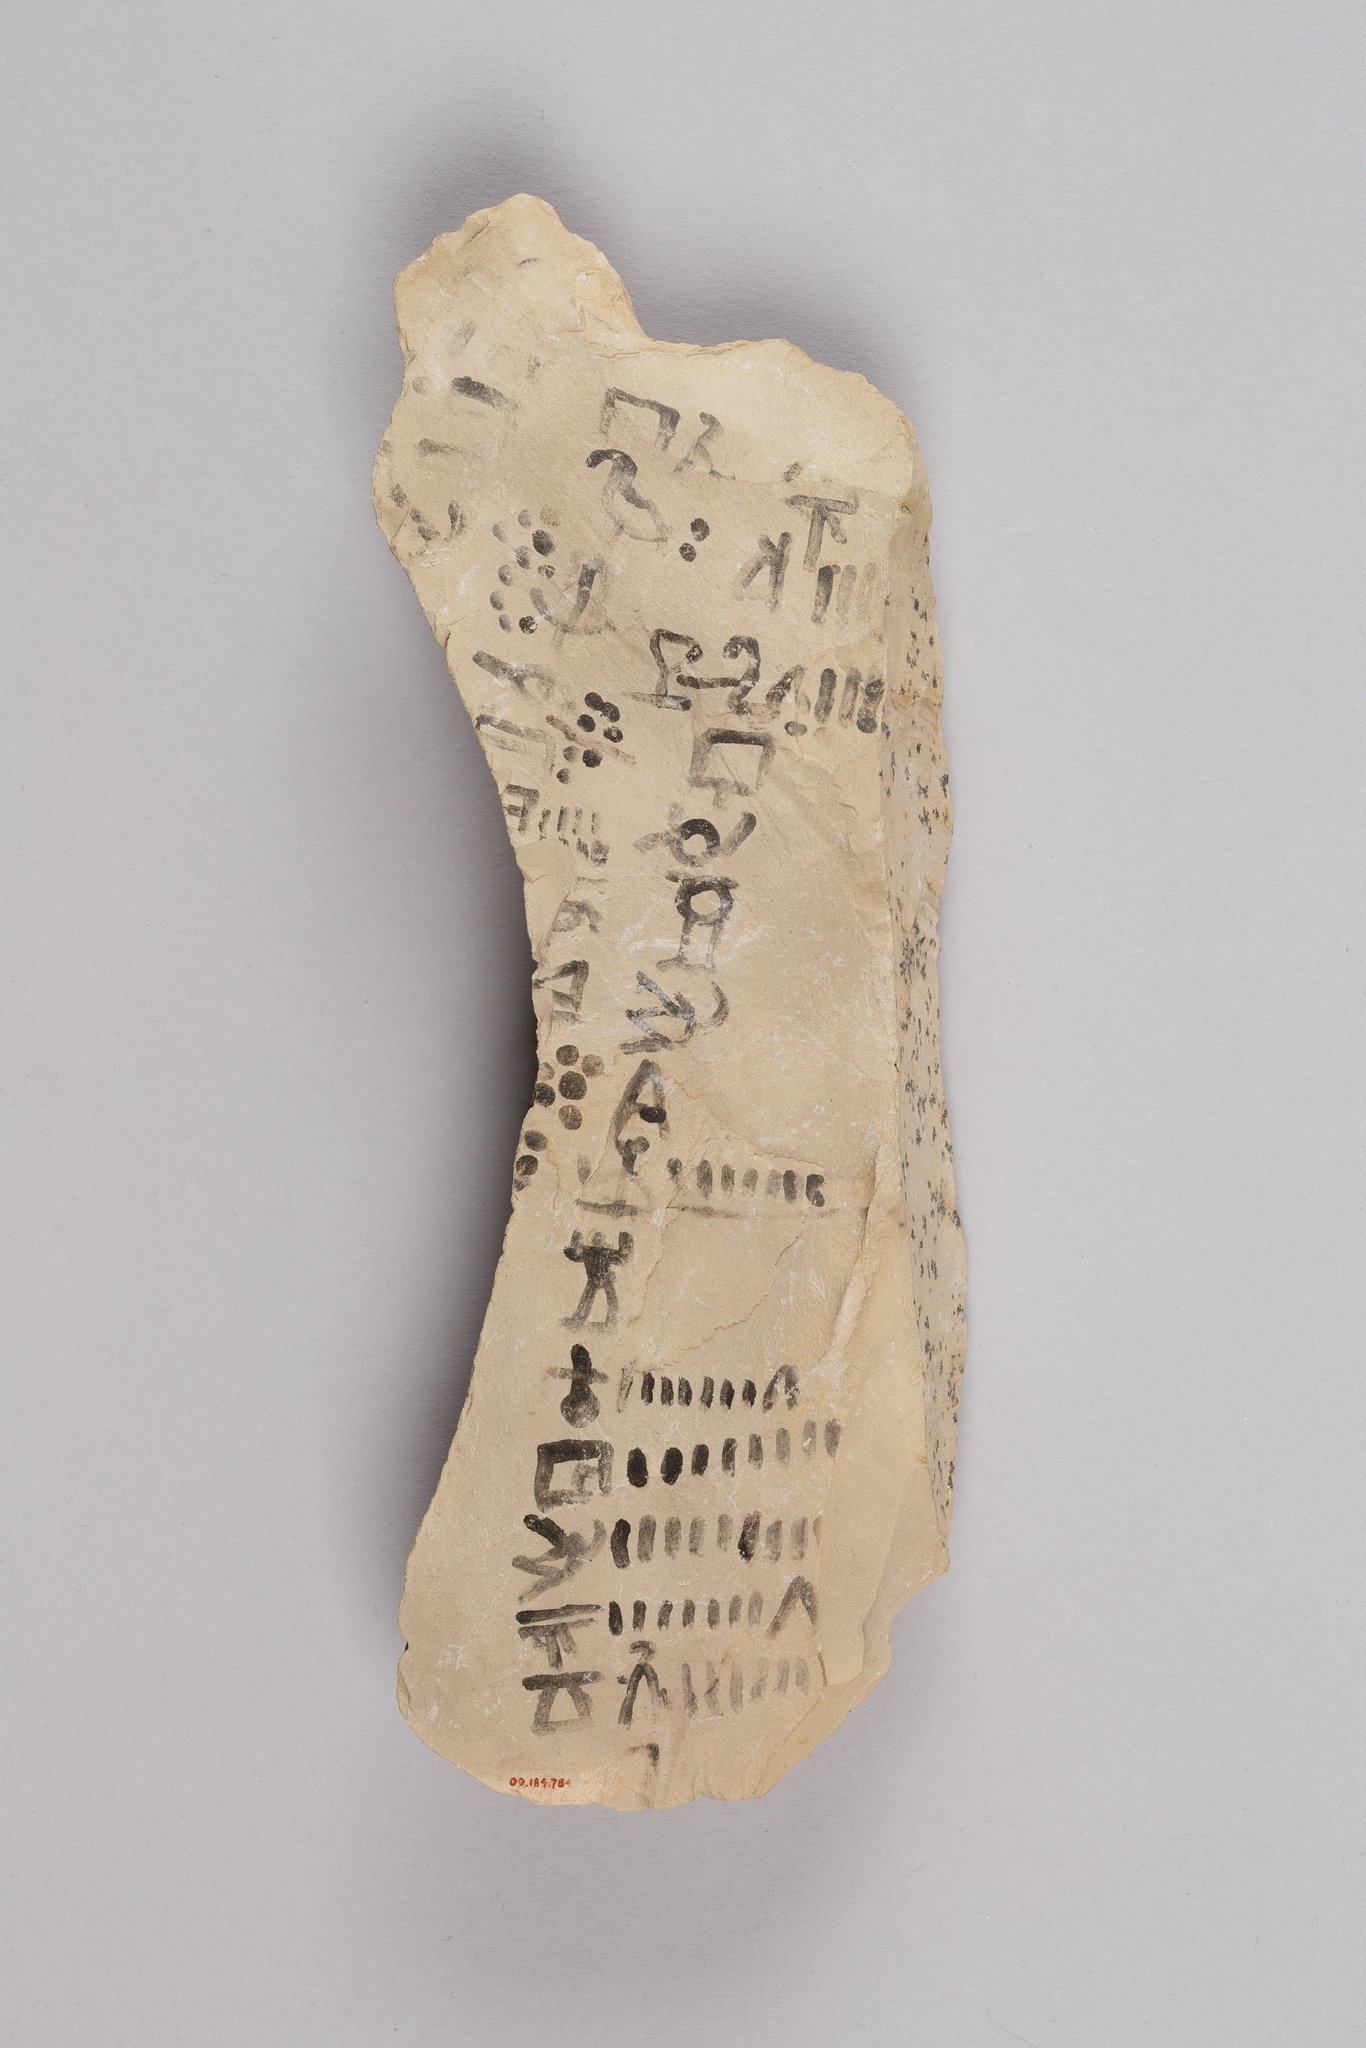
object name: ostracon, identity, mark, necropolis, workman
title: Ostracon inscribed with identity marks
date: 1126-1070 BCE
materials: ink, limestone, paint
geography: egypt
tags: documents